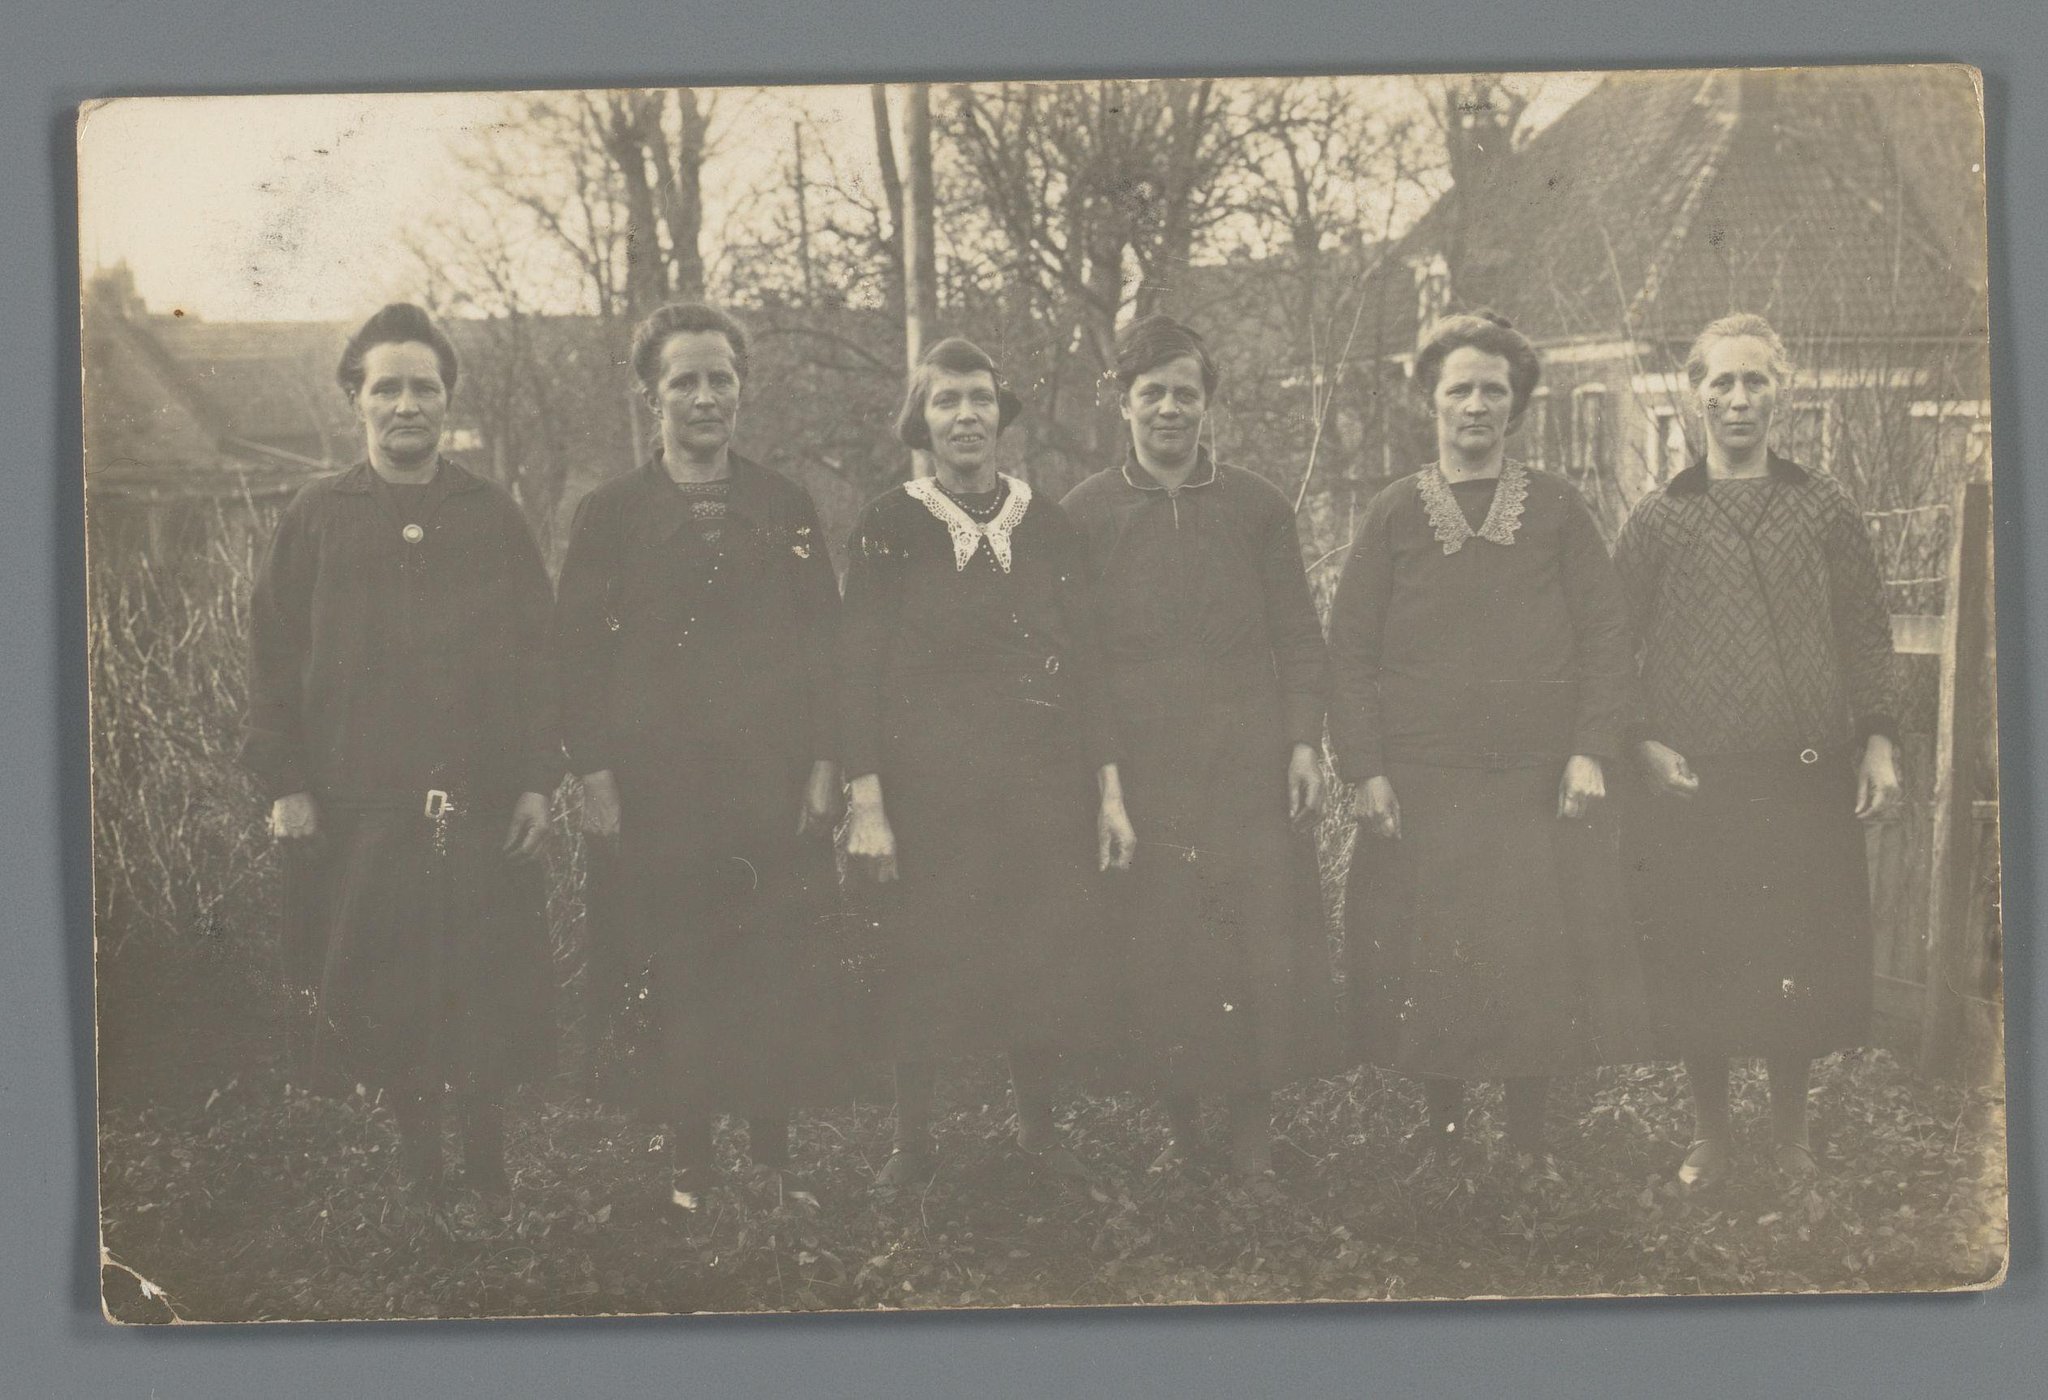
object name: photograph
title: Groepsportret van zes onbekende zussen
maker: Anonymous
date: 1905-1930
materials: paper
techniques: gelatin silver print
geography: netherlands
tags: sisters (second degree family relationships), historical persons not known by name, netherlands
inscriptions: inscription: ‘6 zusters’